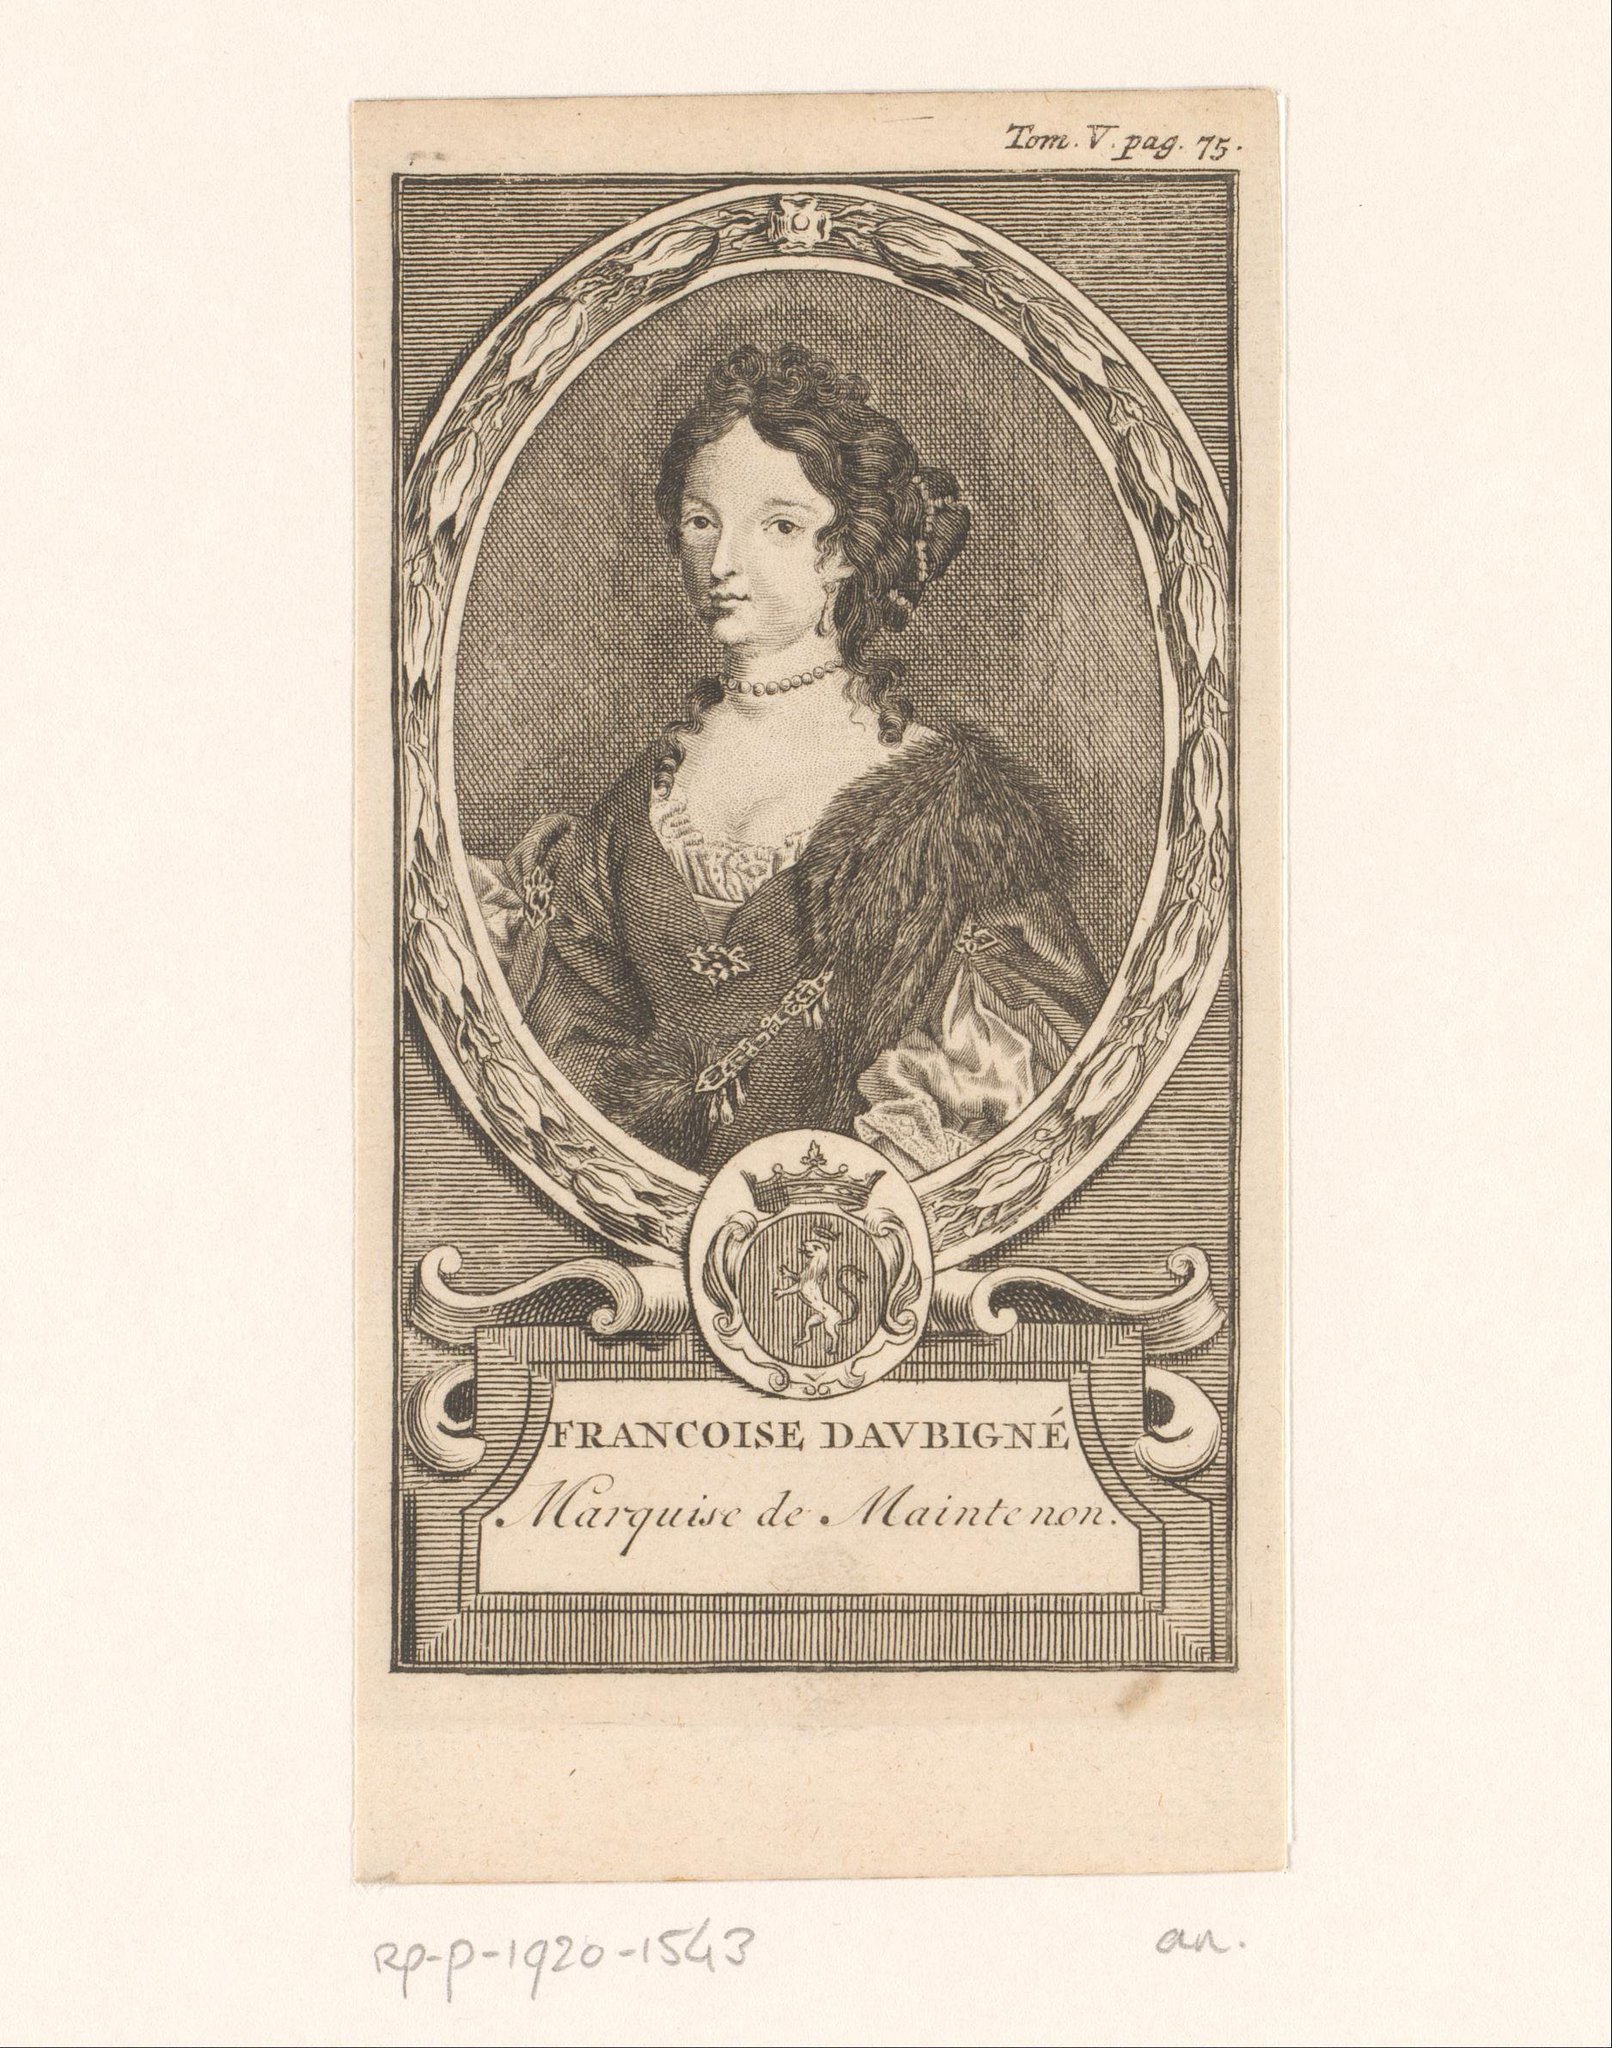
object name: print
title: Francoise dAubigné Marquise de Maintenon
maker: Anonymous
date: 1717-1750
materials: paper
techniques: engraving, etching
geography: northern netherlands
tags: madame de maintenon, historical persons - bb - woman, ornament ~ medallion, armorial bearing, heraldry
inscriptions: inscription: ‘is reeds in Franken/ aanwezig’, collector's mark: Lugt 2228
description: Eerdere staat gebruikt in: Prent waarschijnlijk uit: Limiers, Henri Philippe de. Histoire du regne de Louis XIV (...). Amsterdam: Compagnie, 1717, dl. 4. Deze staat komt uit een onbekende publicatie.